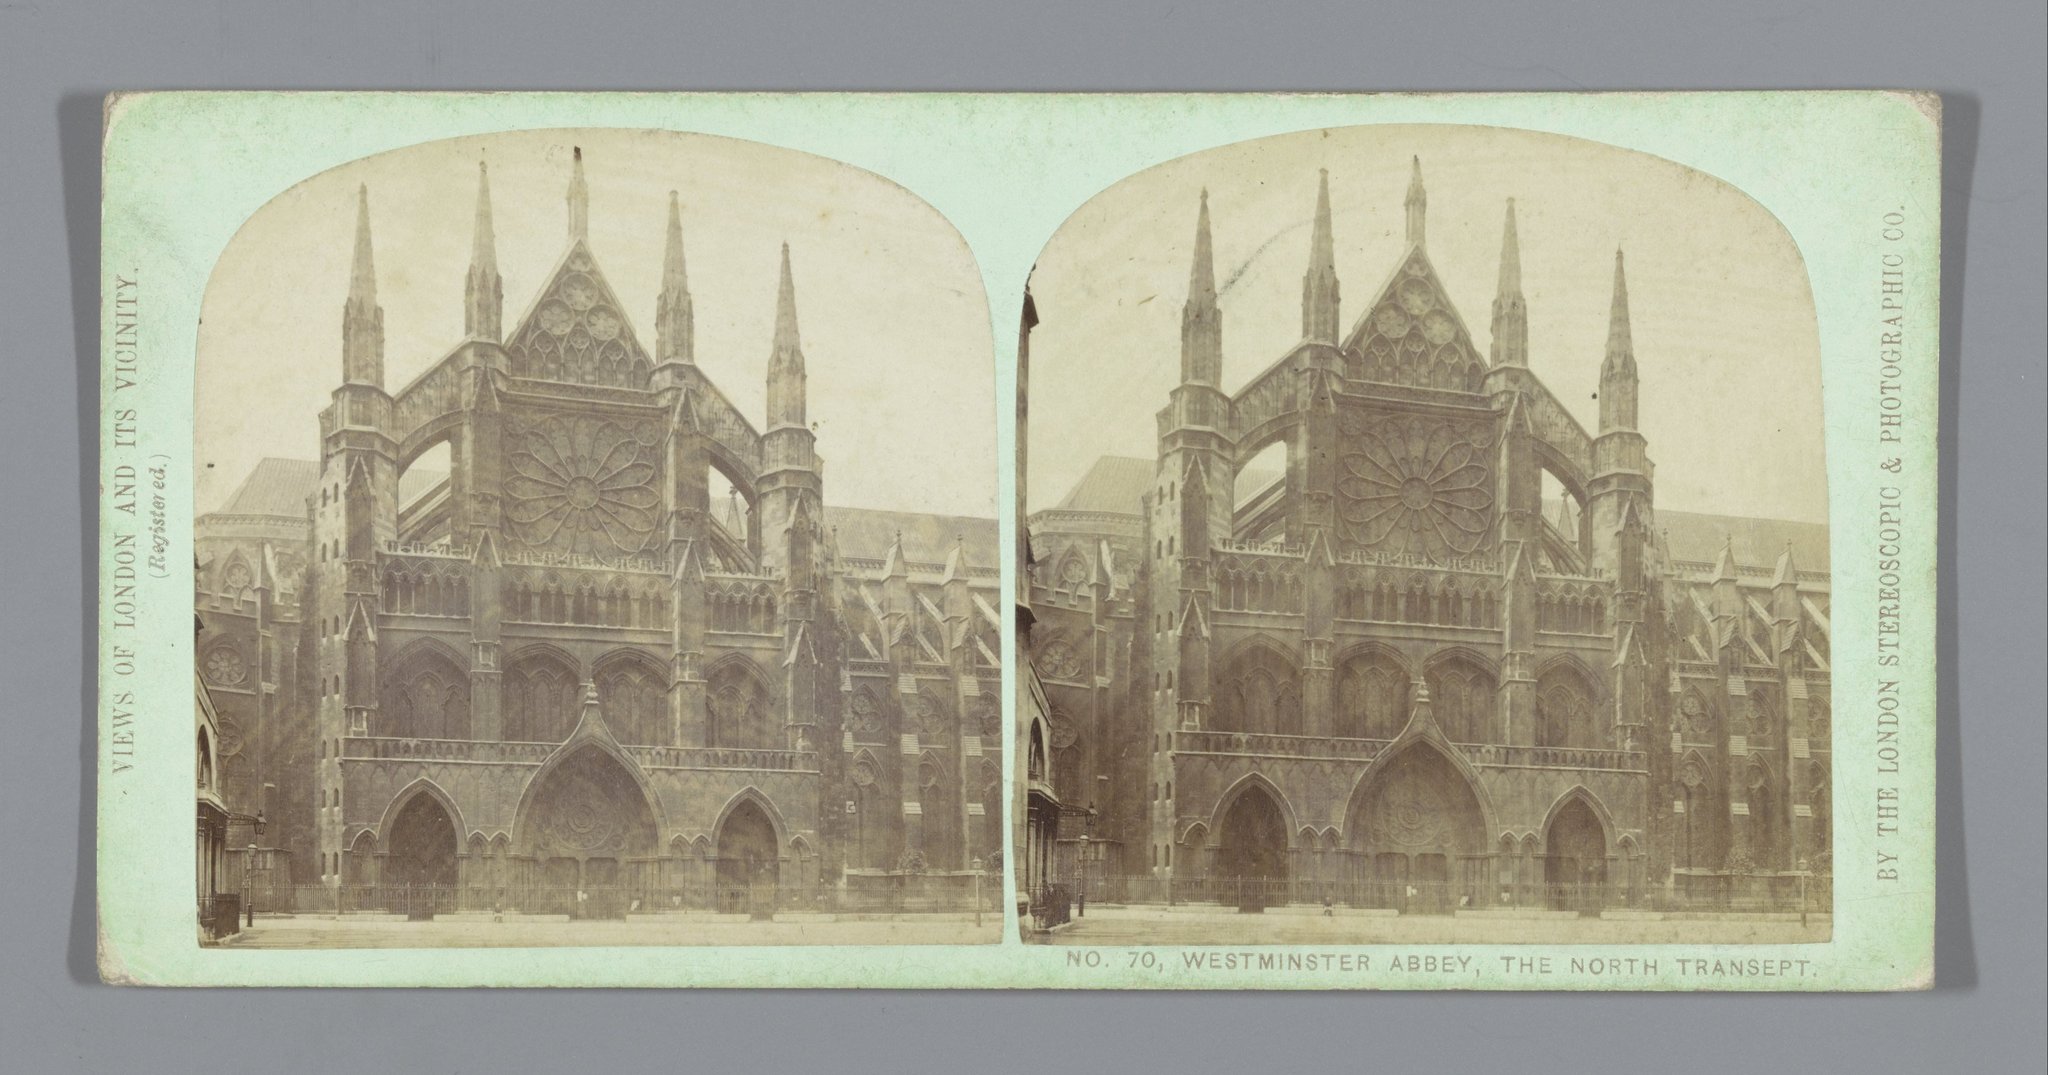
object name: stereograph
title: Views of London and its Vicinity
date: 1854-1880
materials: cardboard, photographic support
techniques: albumen print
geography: london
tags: parts of church exterior and annexes: transept, westminster abbey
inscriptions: number: ‘No. 70’